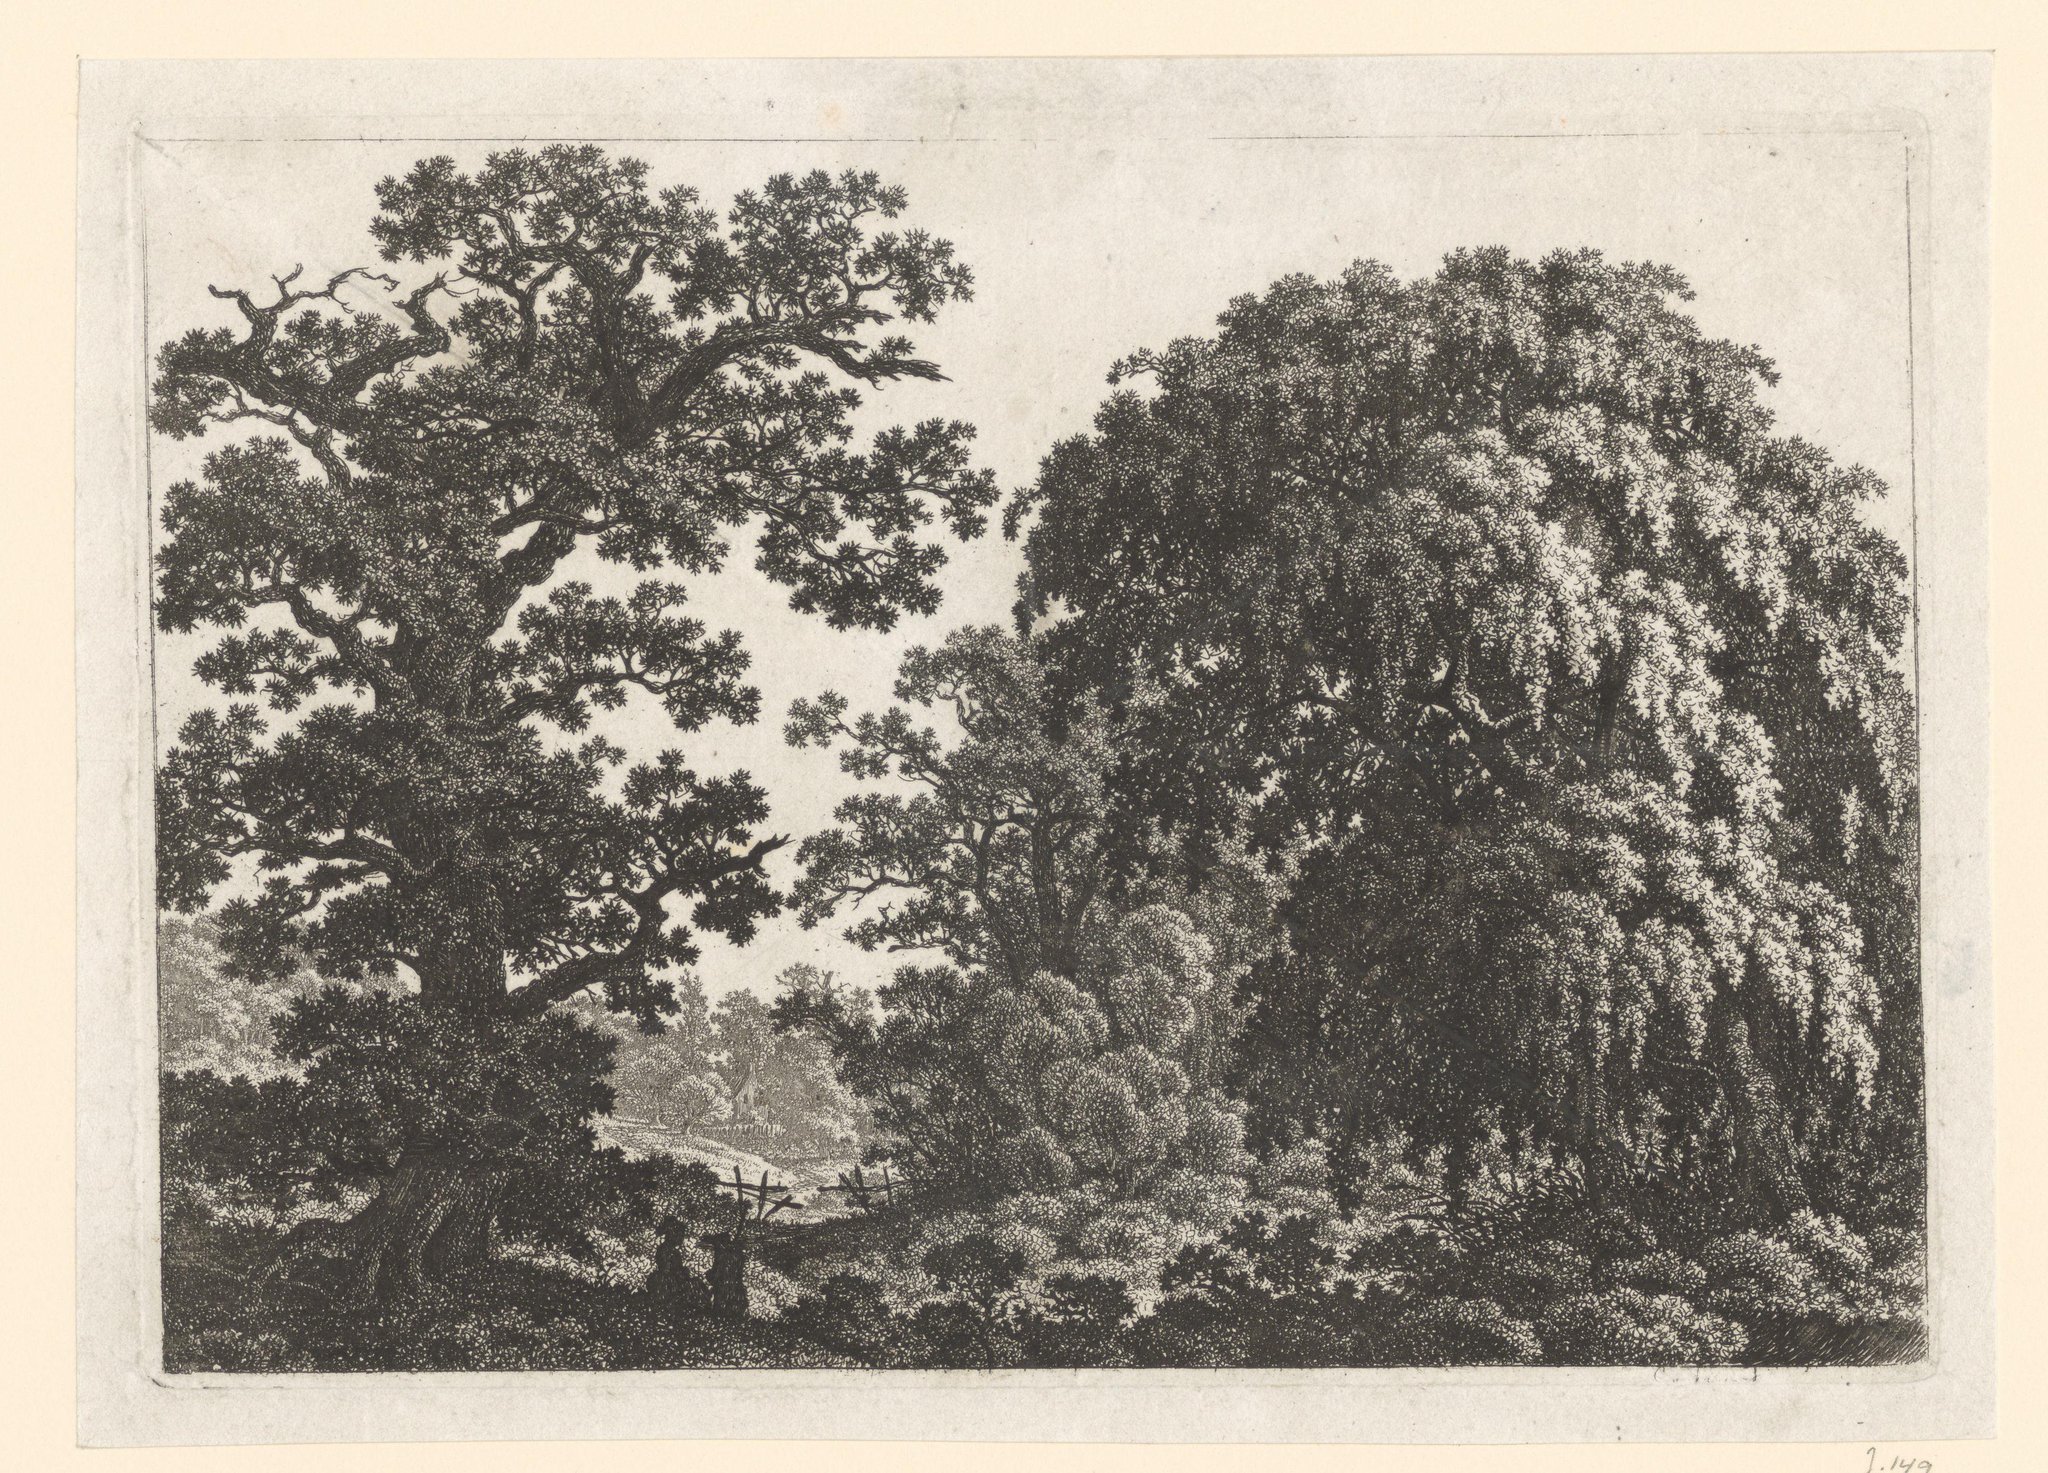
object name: print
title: Bosrijk landschap met doorkijk op een boerderij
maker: carl wilhelm kolbe (i)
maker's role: print maker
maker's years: 1757-1835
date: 1767-1797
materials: paper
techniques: etching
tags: forest, wood, farm or solitary house in landscape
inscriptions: collector's mark: Lugt 2760, collector's mark: Lugt 2228